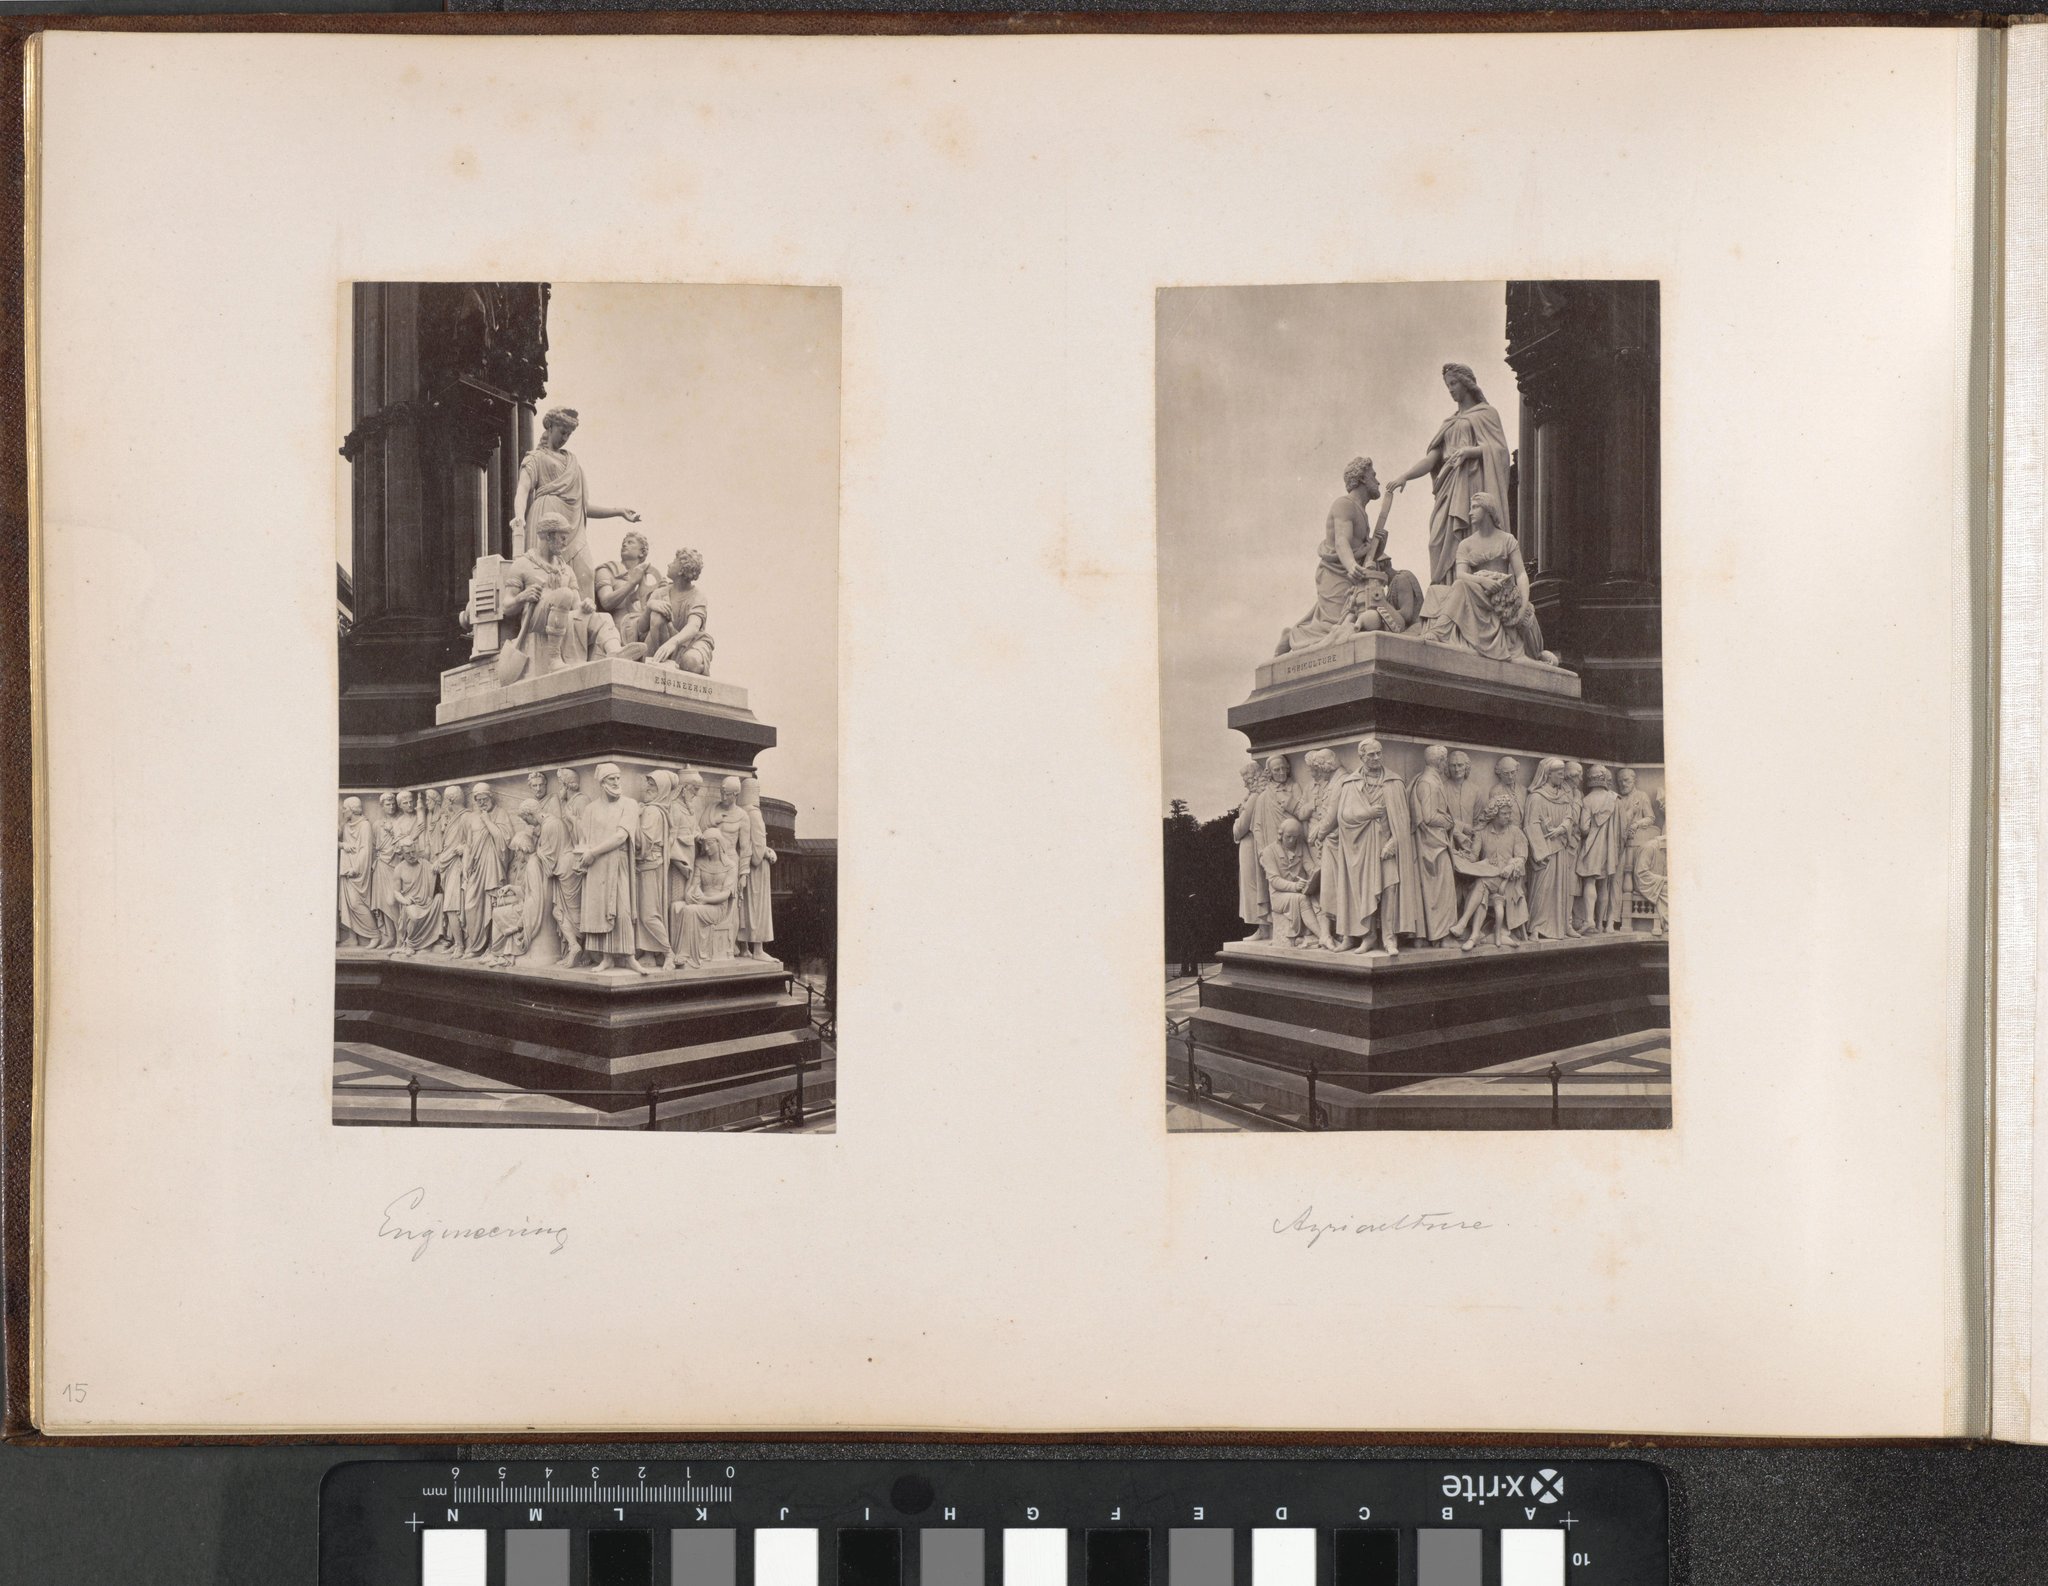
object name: photograph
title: Engineering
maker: Anonymous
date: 1878-1890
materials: photographic support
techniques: albumen print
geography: london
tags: piece of sculpture, reproduction of a piece of sculpture (+ sculpture), monument, statue, london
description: Onderdeel van Reisalbum Europese steden, vermoedelijk Zweeds.